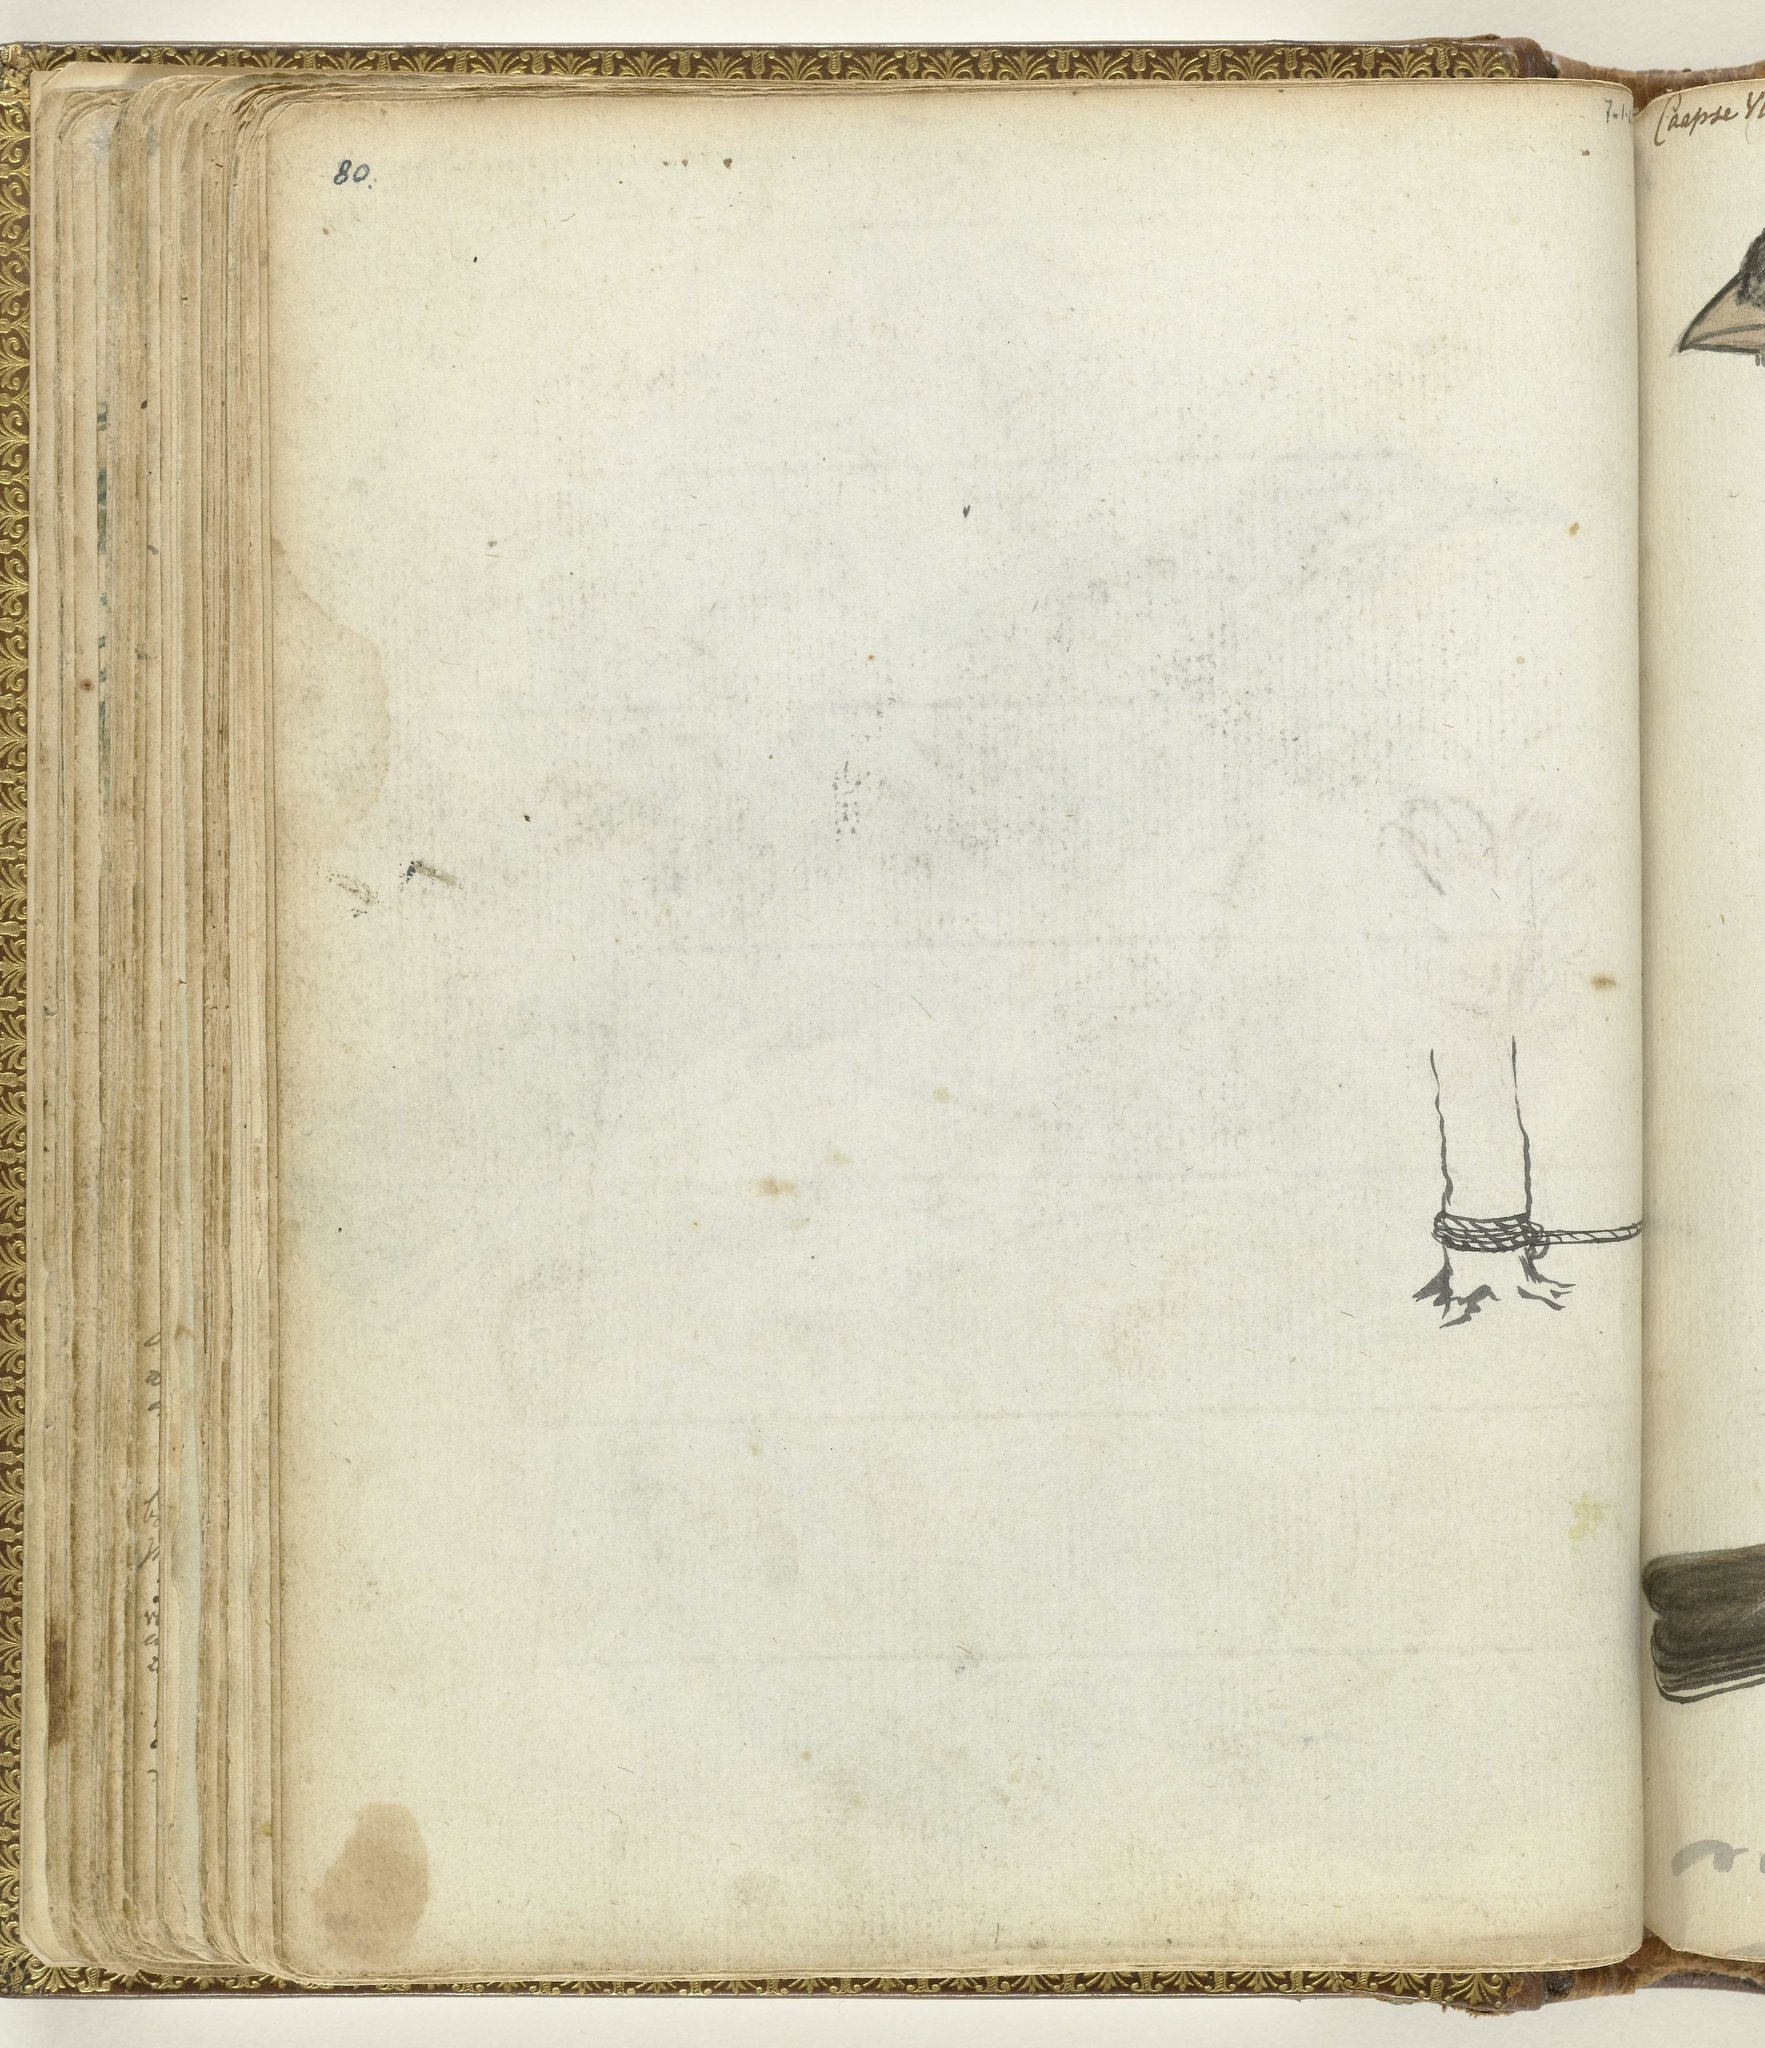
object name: drawing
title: Boom met touw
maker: jan brandes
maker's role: draughtsman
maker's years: 1743-1808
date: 1785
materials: paper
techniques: brush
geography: sri lanka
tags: tools, aids, implements ~ crafts and industries: rope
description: Zwartwittekening van een deel van een boom en een daaraan bevestigd strakgespannen deel van een touw. Hoort ter linkerzijde van: deel 2, p.137. Onderdeel uit het schetsboek van Jan Brandes, dl. 1 (1808), p. 80.